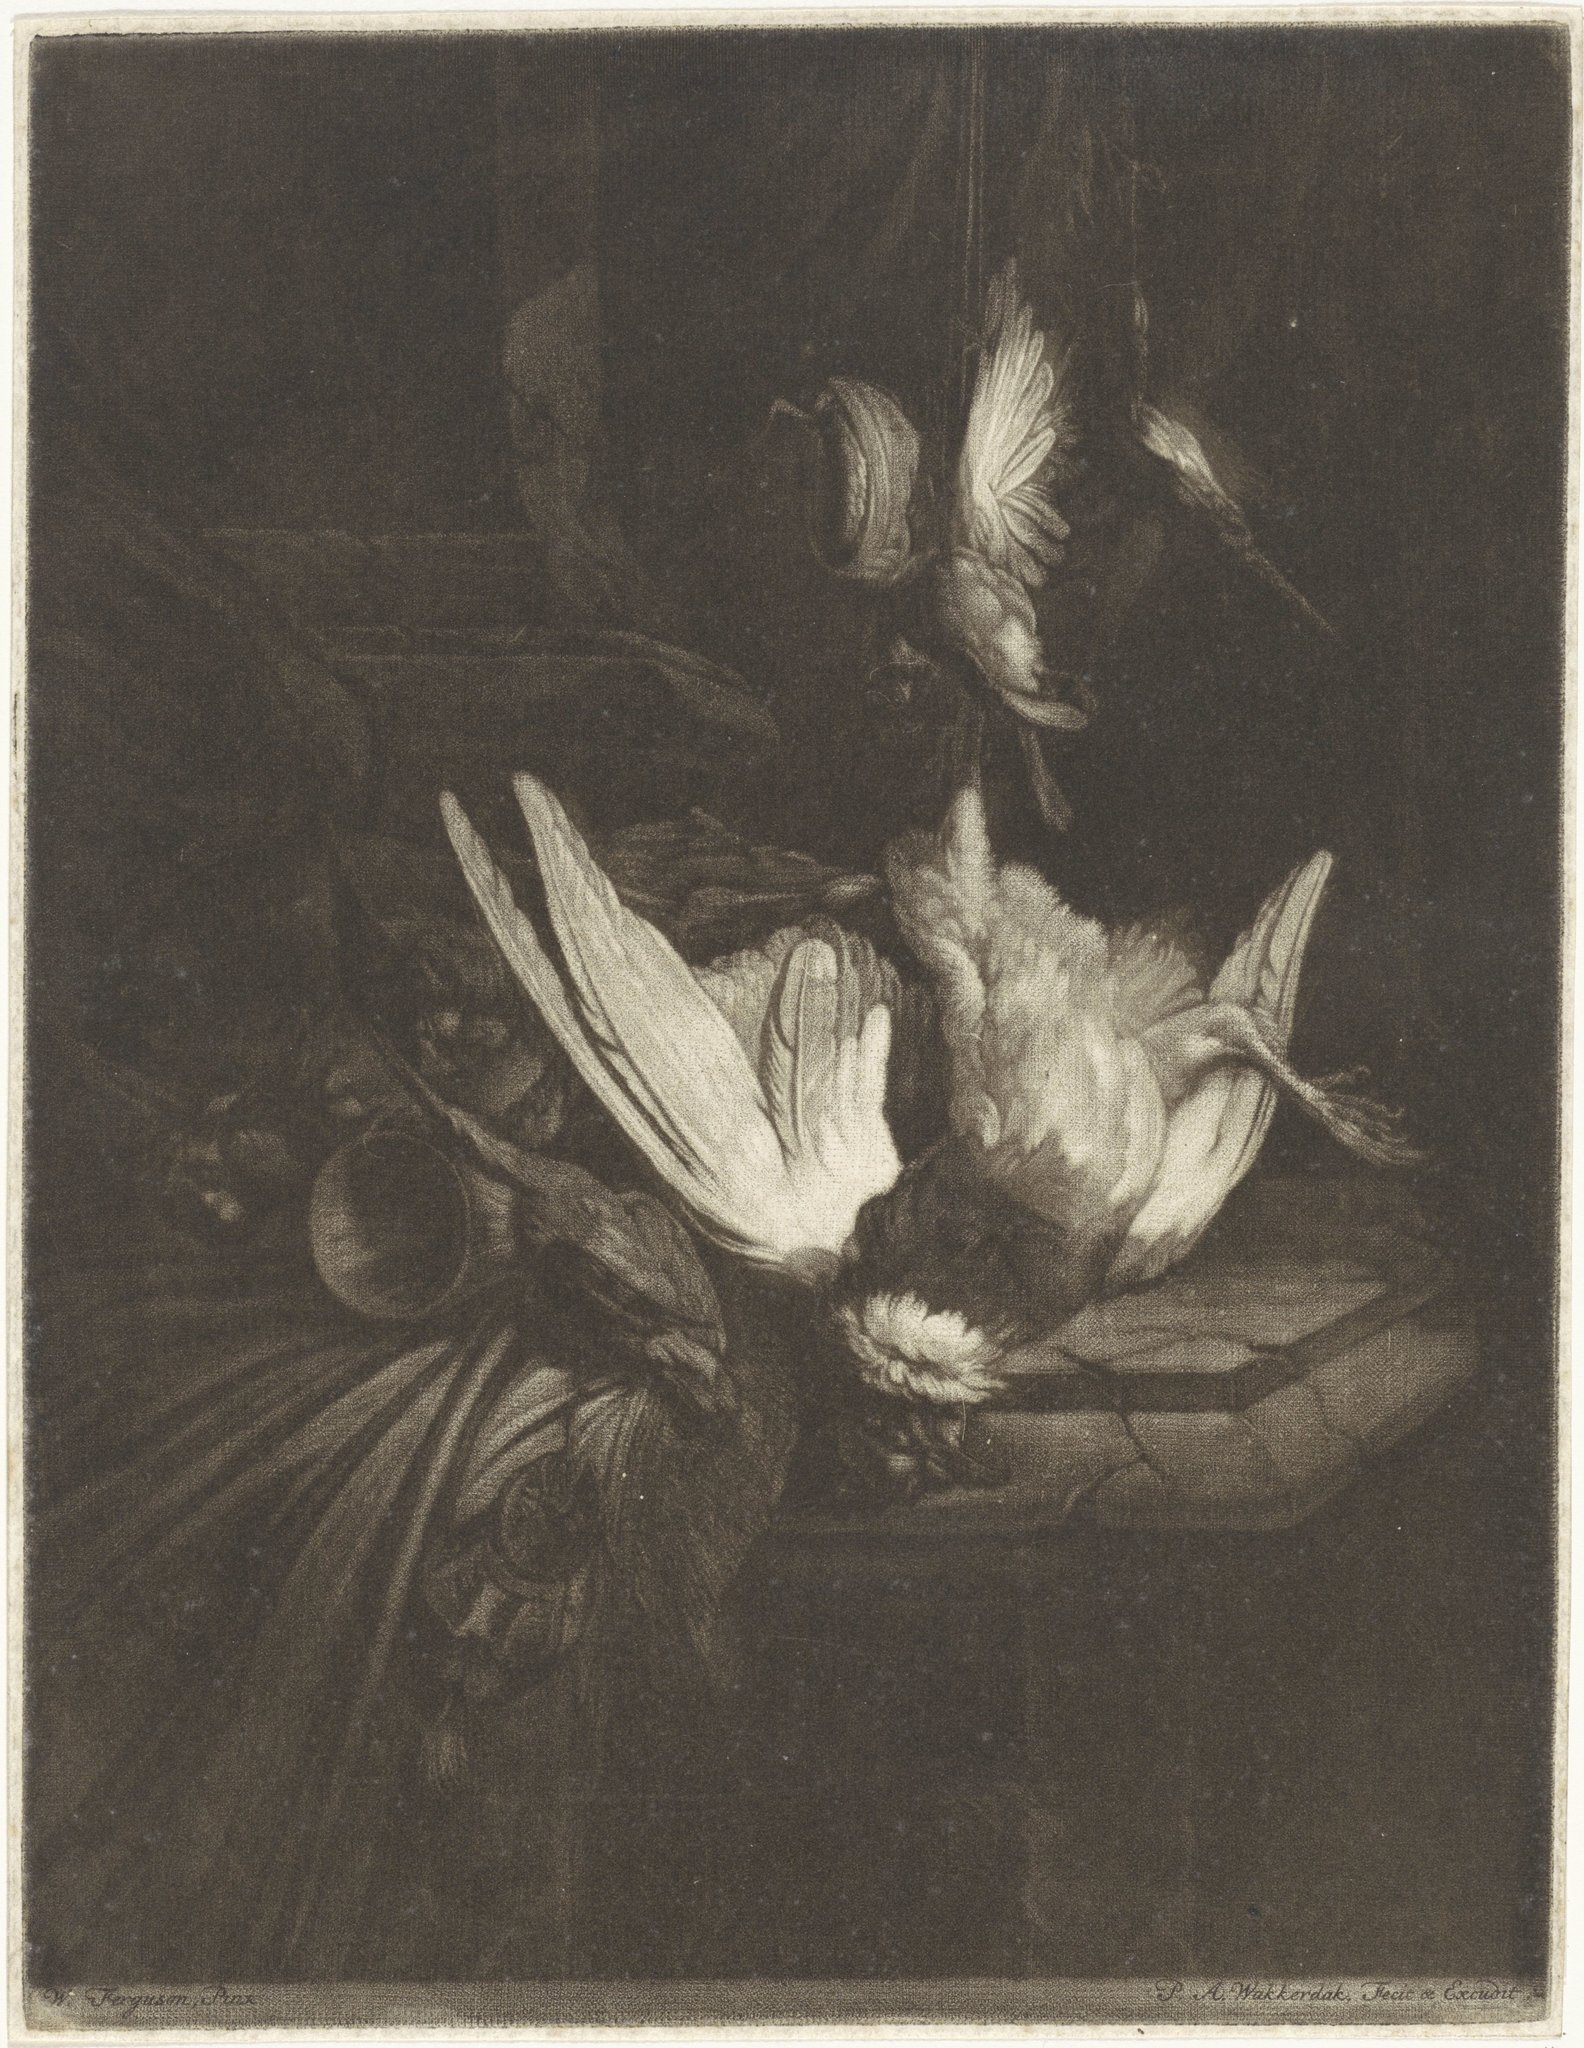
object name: print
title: Stilleven met gevogelte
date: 1740-1774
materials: paper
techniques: mezzotint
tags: birds, still life of related objects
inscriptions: collector's mark: Lugt 2228